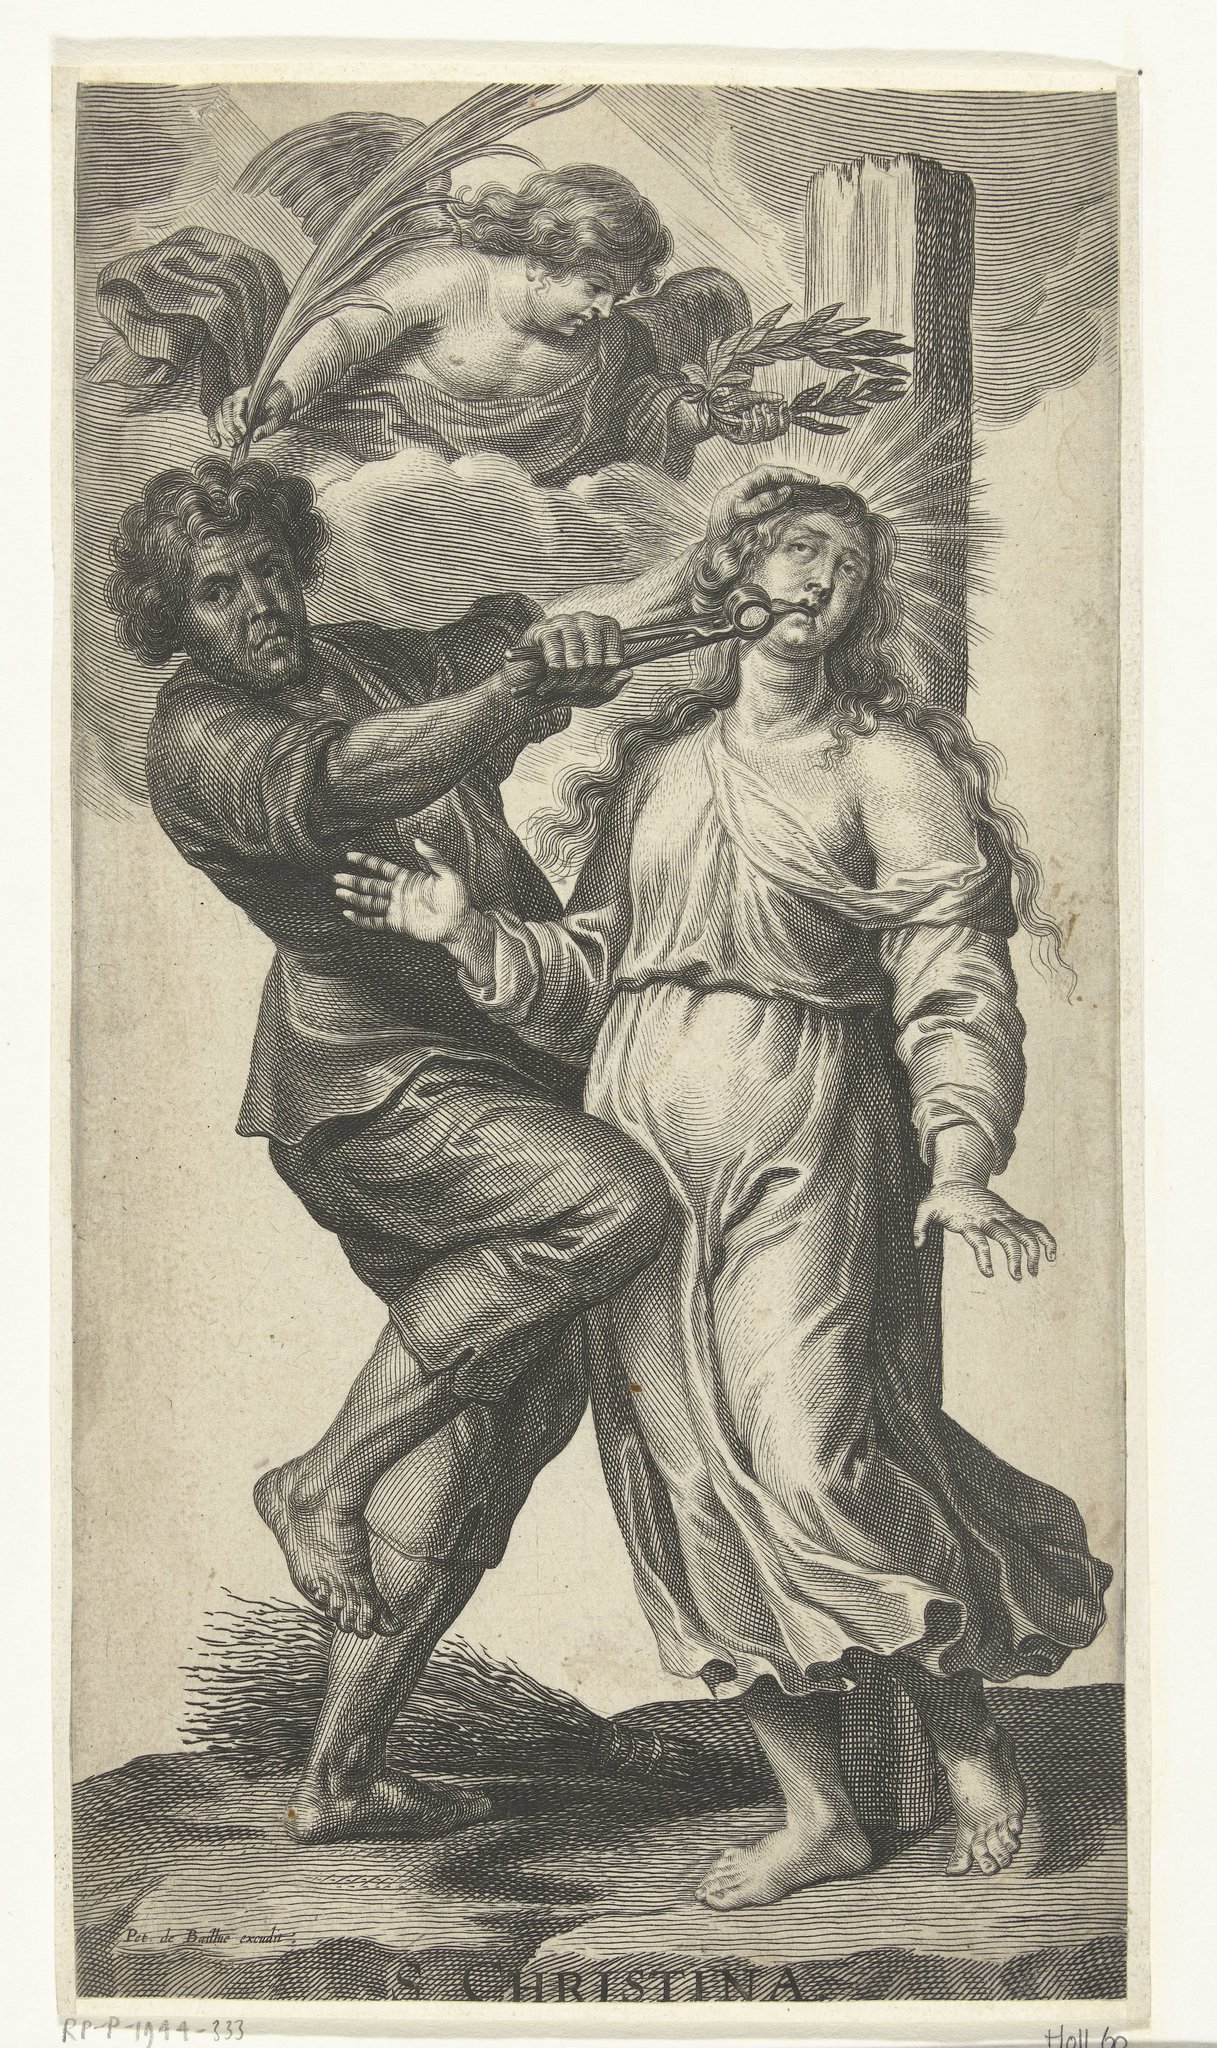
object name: print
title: Heilige Christina als martelares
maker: pieter de bailliu (i)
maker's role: print maker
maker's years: 1613-1660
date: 1623-1660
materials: paper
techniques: engraving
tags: violent death by tearing out of tongue, the virgin martyr christina of bolsena; possible attributes: arrow(s), book, flames, millstone, tongs, snake, wheel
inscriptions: collector's mark: Lugt 2228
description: Een vrouwelijke heilige of martelares staat voor een paal of zuil en wordt door een man stevig vastgehouden terwijl hij met een tang haar tong uit haar mond trekt.